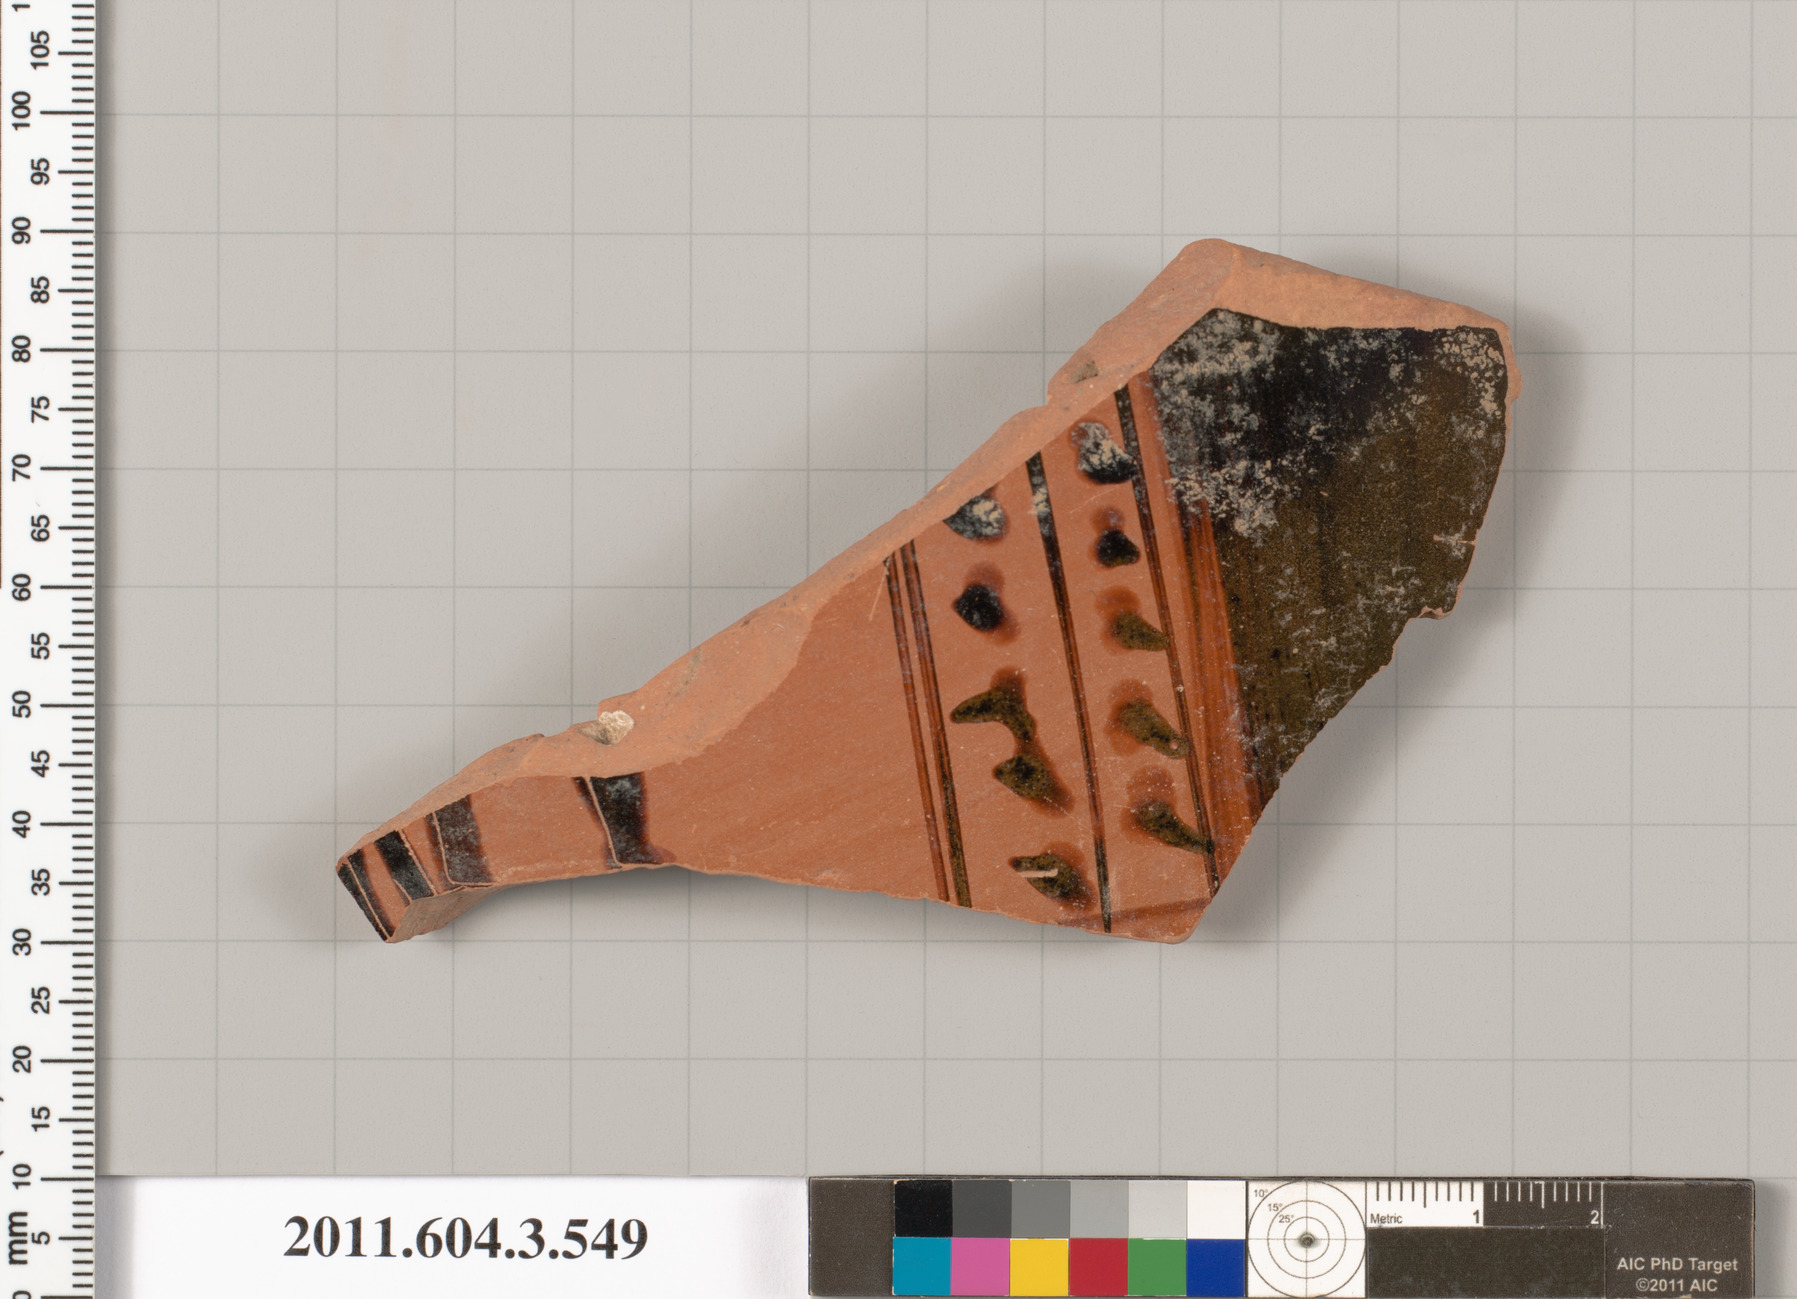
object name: column krater fragment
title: Terracotta fragment of a column-krater (bowl for mixing wine and water)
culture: greek, attic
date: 500-468 BCE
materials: terracotta